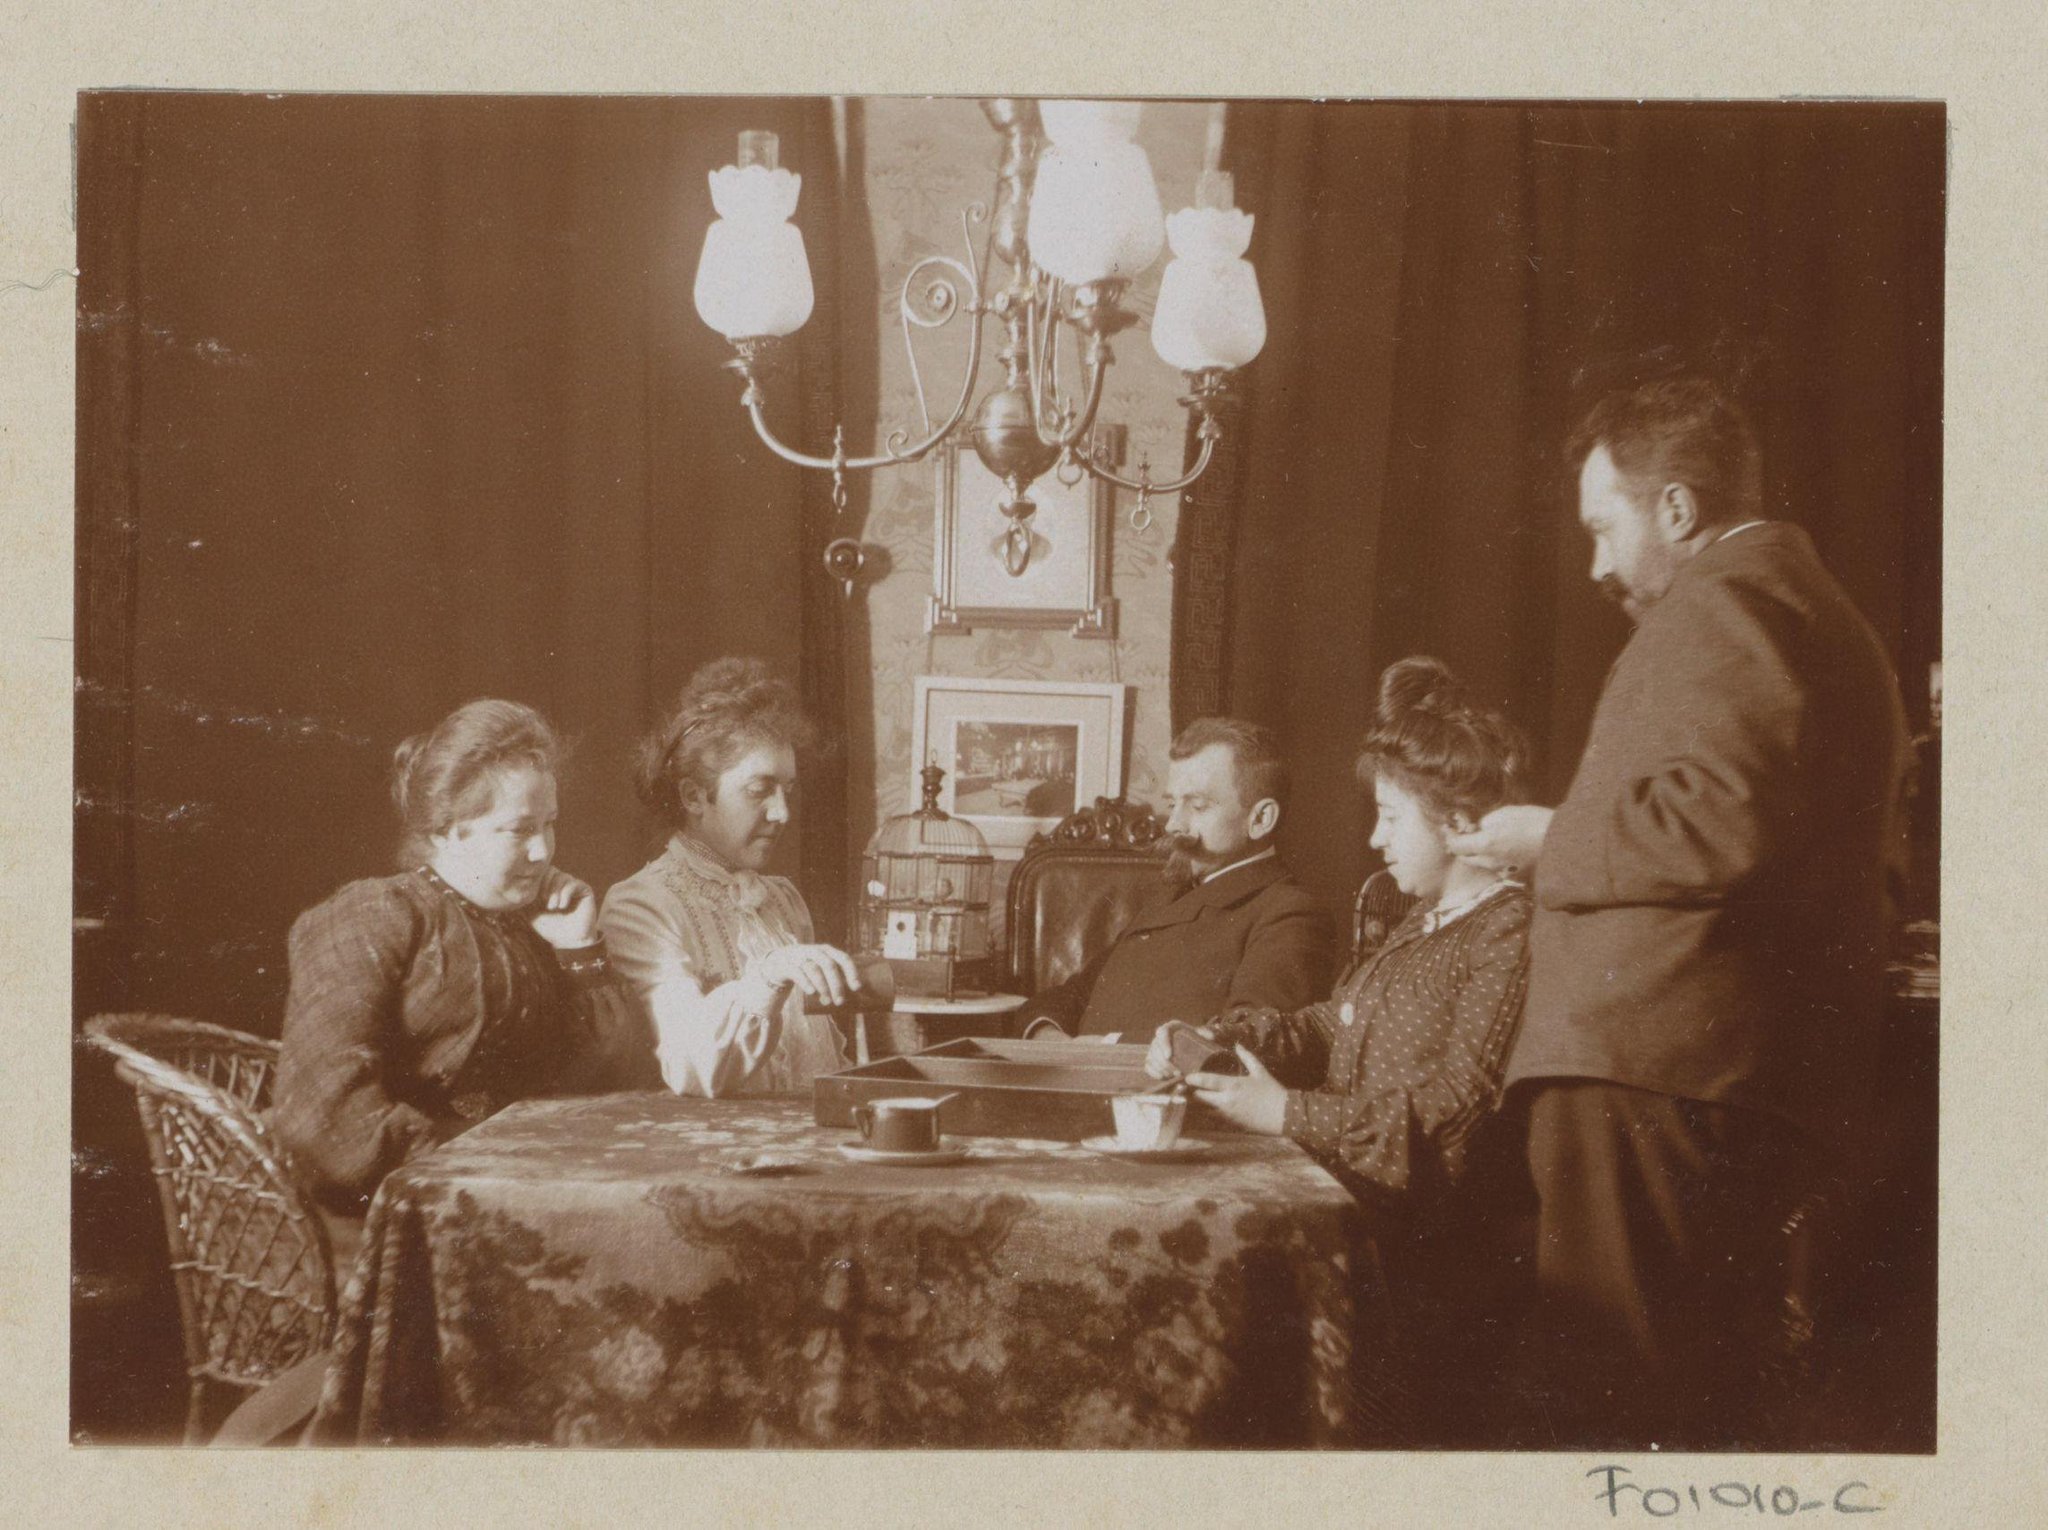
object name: photograph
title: Mannen en vrouwen spelen een bordspel in een woonkamer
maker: Anonymous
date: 1900-1910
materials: photographic support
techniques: collodion silver print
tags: interior of the house, board-games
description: Onderdeel van Familiealbum met onder meer foto's van Wijnhandel Kraaij & Co. Bordeaux-Amsterdam.